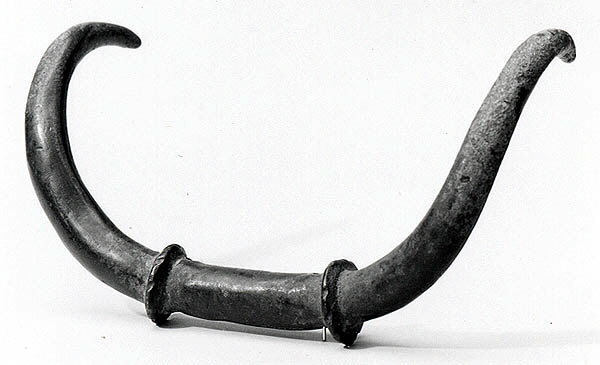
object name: sculpture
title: Bull's horns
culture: hattian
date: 2300-2000 BCE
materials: copper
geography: central anatolia